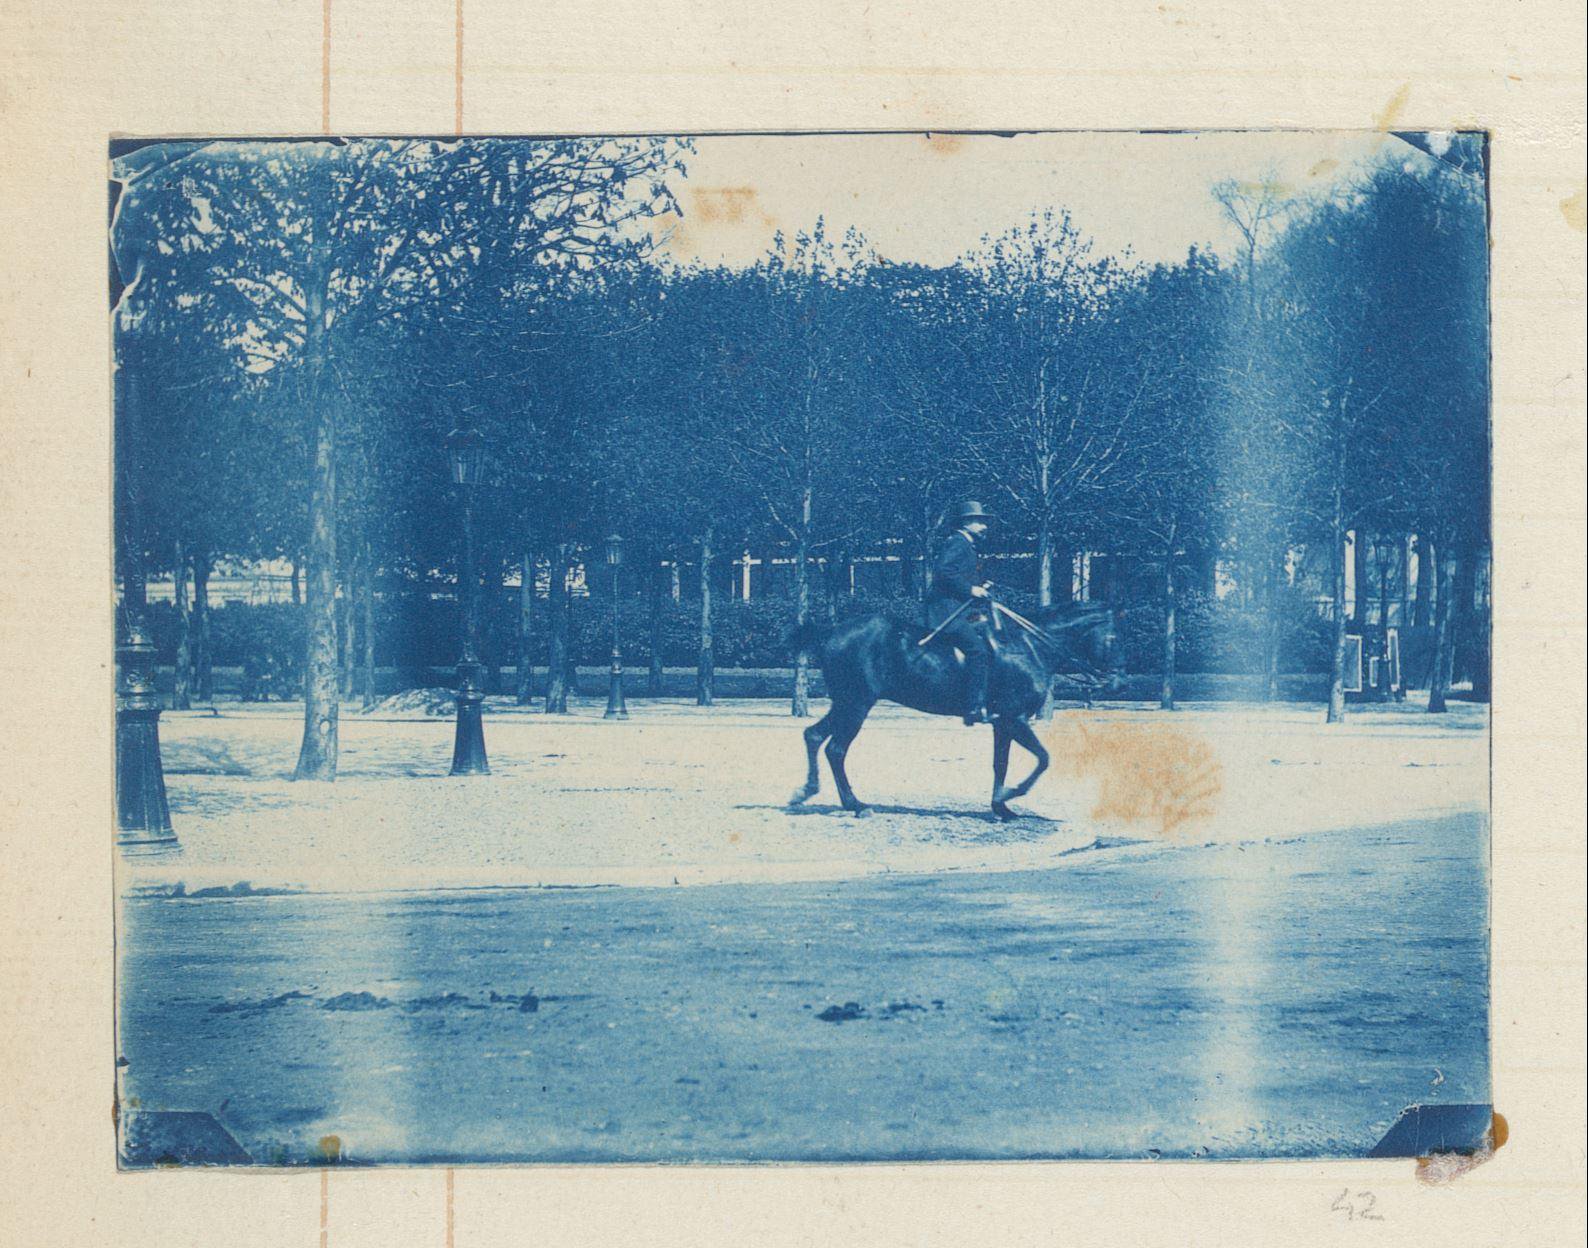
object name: photograph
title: Man met hoed te paard in een park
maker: Anonymous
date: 1880-1900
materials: paper, photographic support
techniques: cyanotype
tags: riding a horse, ass, or mule; rider, horseman